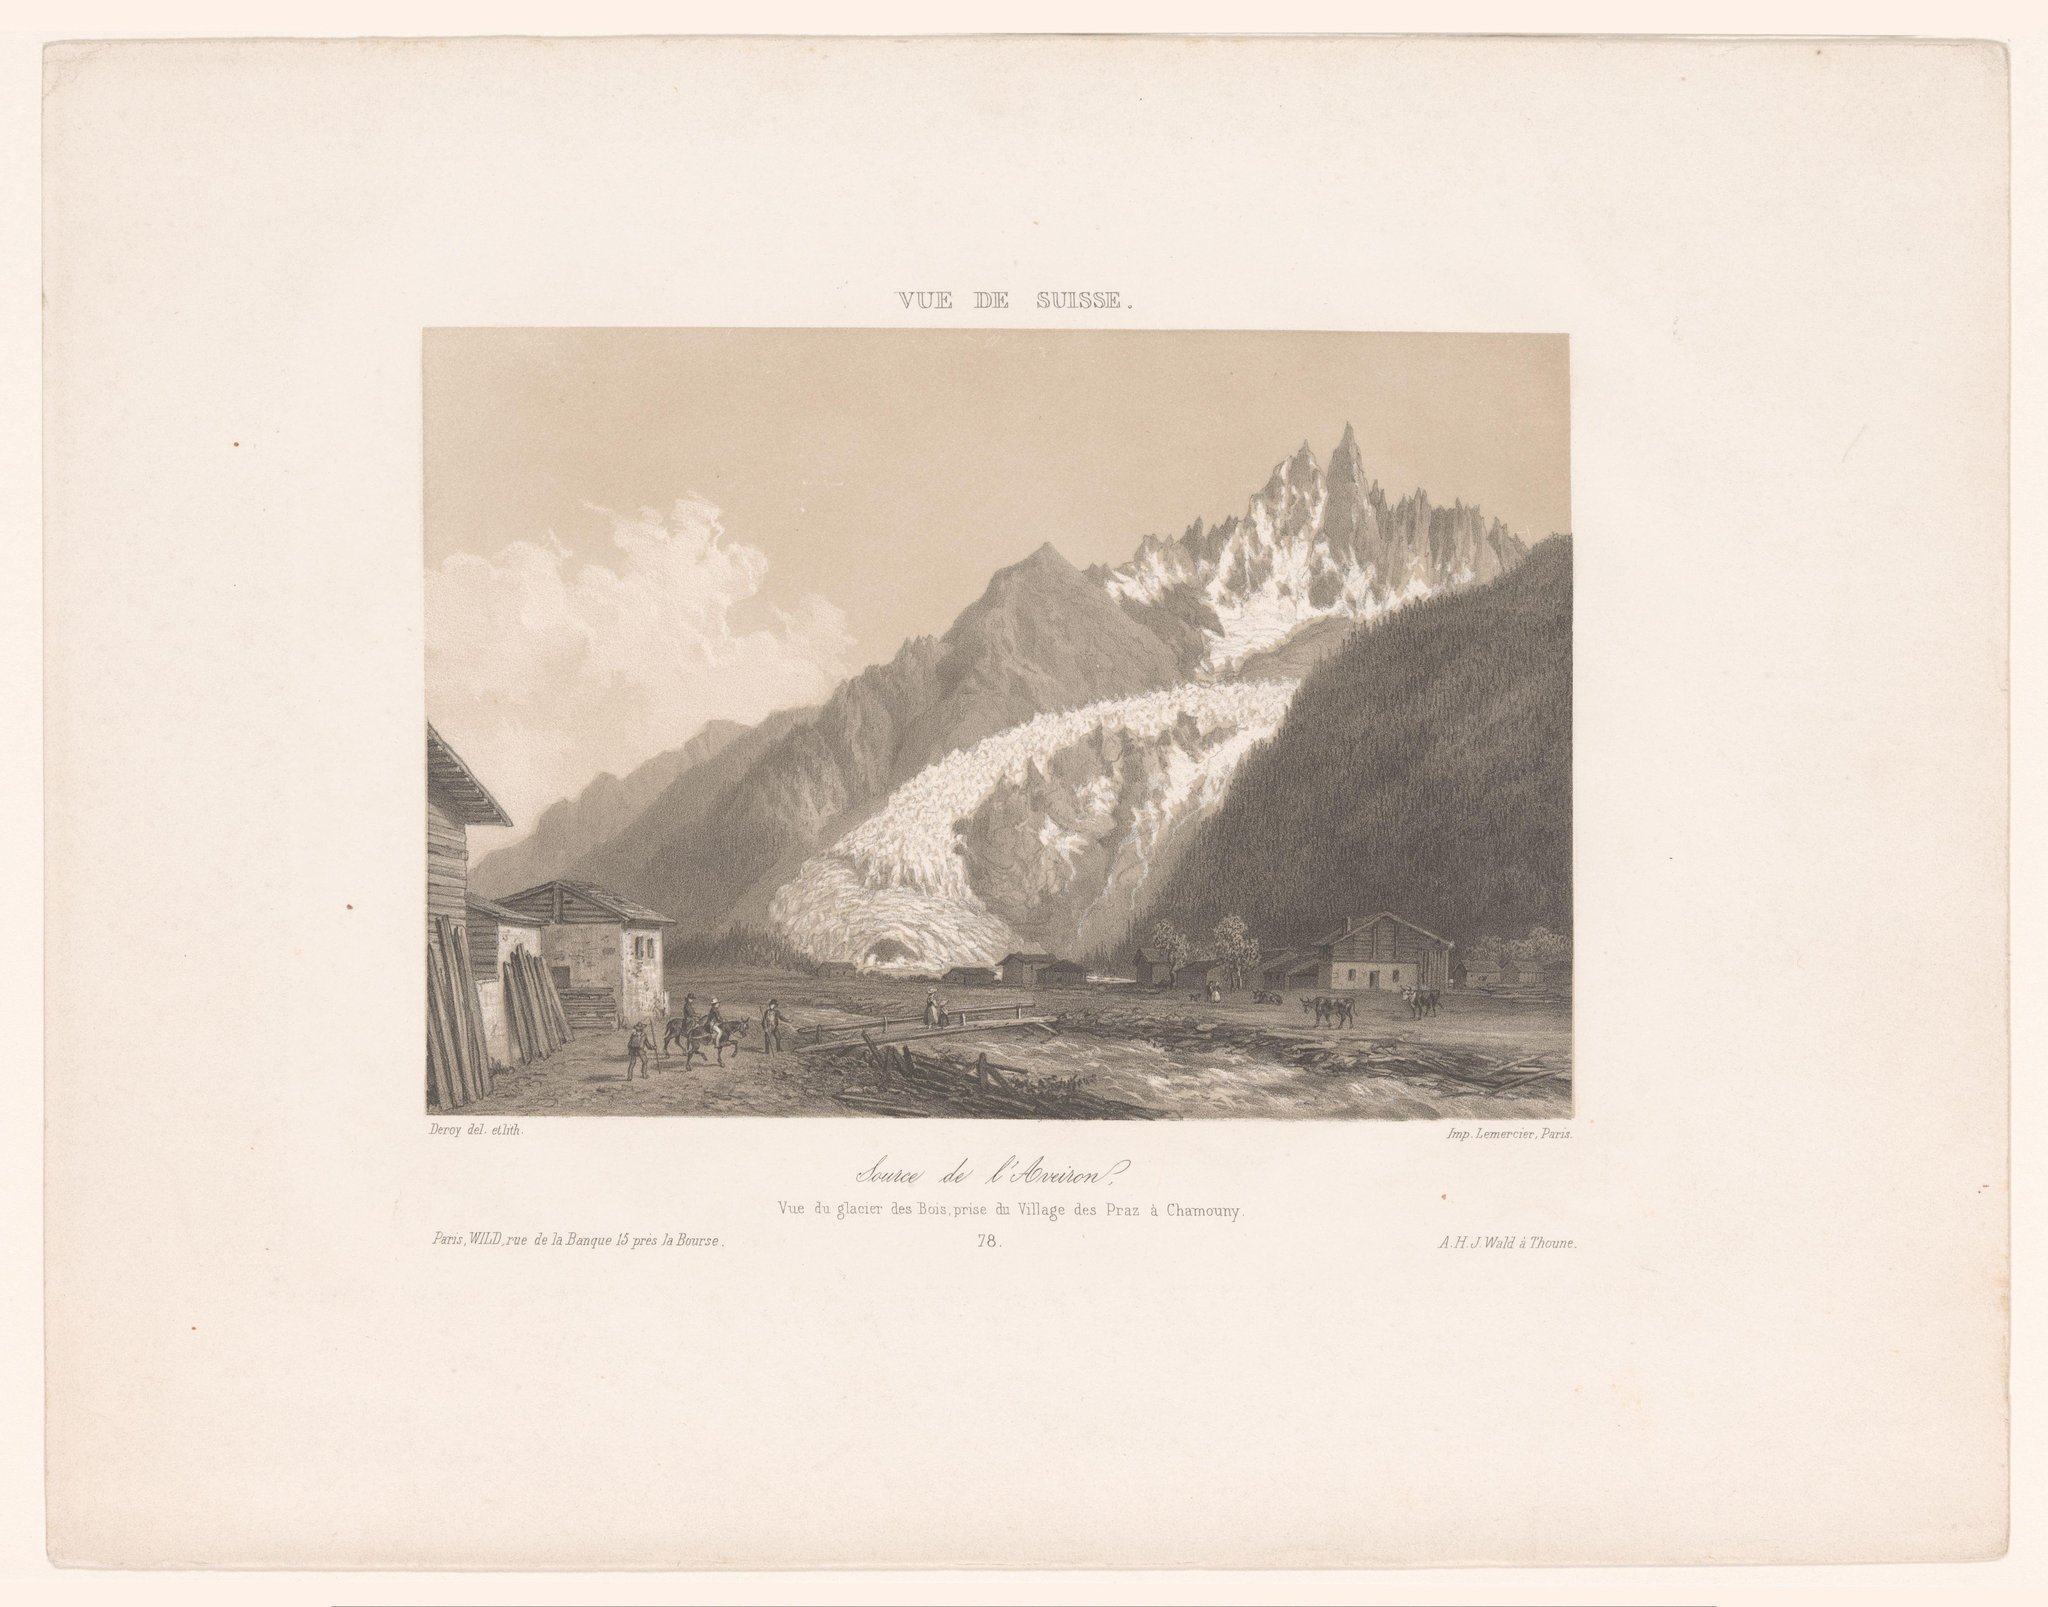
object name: print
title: Gezichten in Zwitserland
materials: paper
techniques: tone lithography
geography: thun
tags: glacier (+ landscape with figures, staffage)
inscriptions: collector's mark: Lugt 2228a